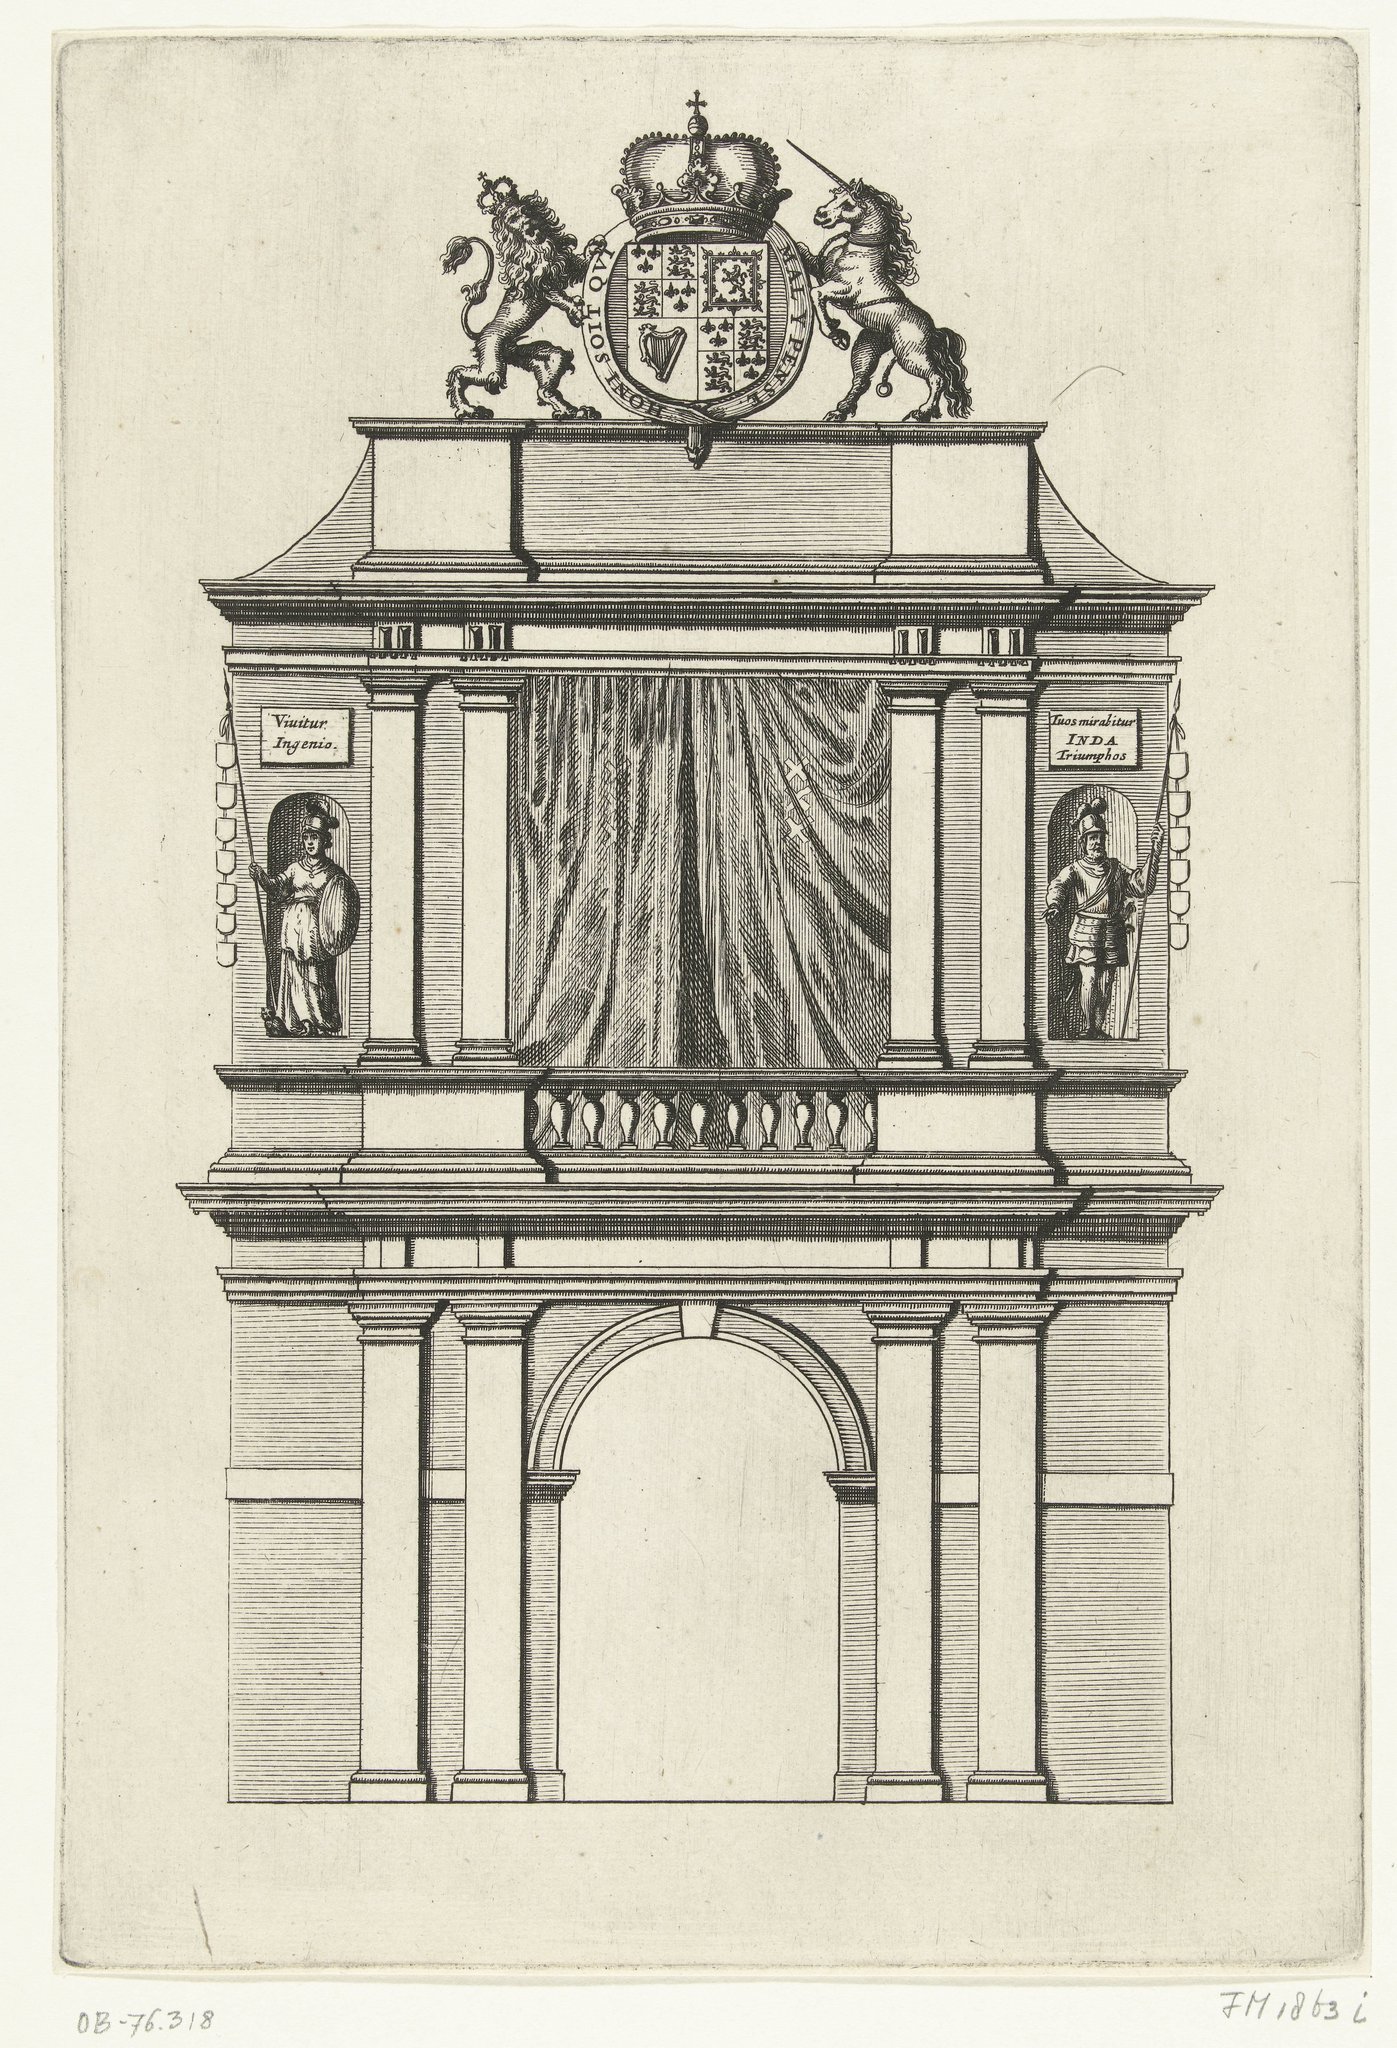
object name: print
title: Theaterpoort opgericht op de Damsluis, 1642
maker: pieter nolpe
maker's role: draughtsman, print maker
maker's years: 1613-1653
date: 1642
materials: paper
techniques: etching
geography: northern netherlands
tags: henriëtta maria van frankrijk (koningin van engeland, schotland en ierland), triumphal arch, triumphal entry and public reception, pageant, 'entrée solennelle', 'joyeuse entrée', the stage and its equipment, amsterdam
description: Theaterpoort opgericht op de Damsluis. Bovenaan het wapen van de Engelse koning Karel I, aan de zijden beelden van Pallas en Mars. Toneel voor de vertoningen tijdens het bezoek van Engelse koningin Henrietta Maria aan Amsterdam, 20-22 mei 1642. Negende plaat in een groep van tien vertoningen en triomfbogen.